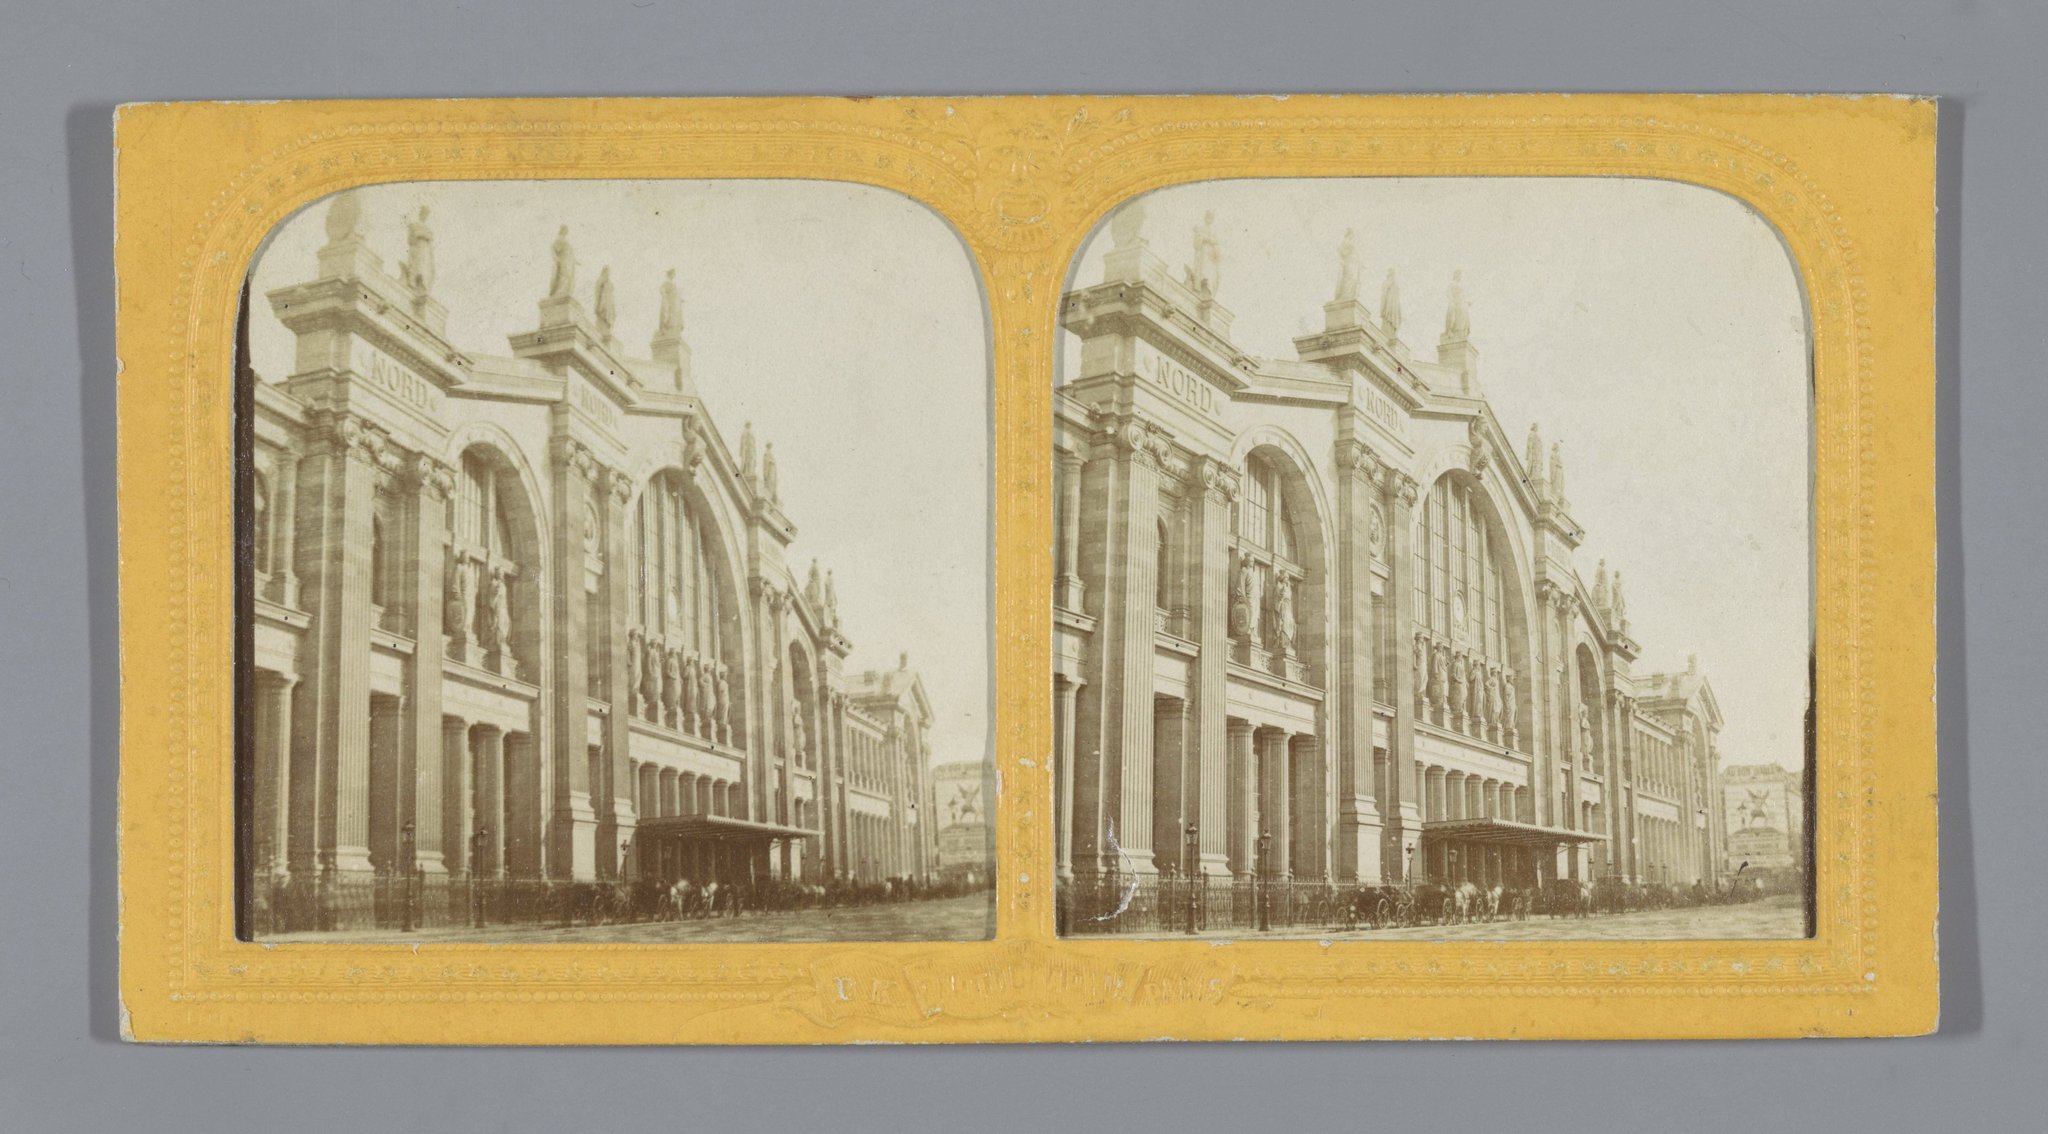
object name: tissue stereograph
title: Façade van het Gare du Nord, Parijs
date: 1866-1875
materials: cardboard, paper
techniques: albumen print, hand coloring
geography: paris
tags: station; shelter (railway, tramway)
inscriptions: inscription: ‘Déposé’